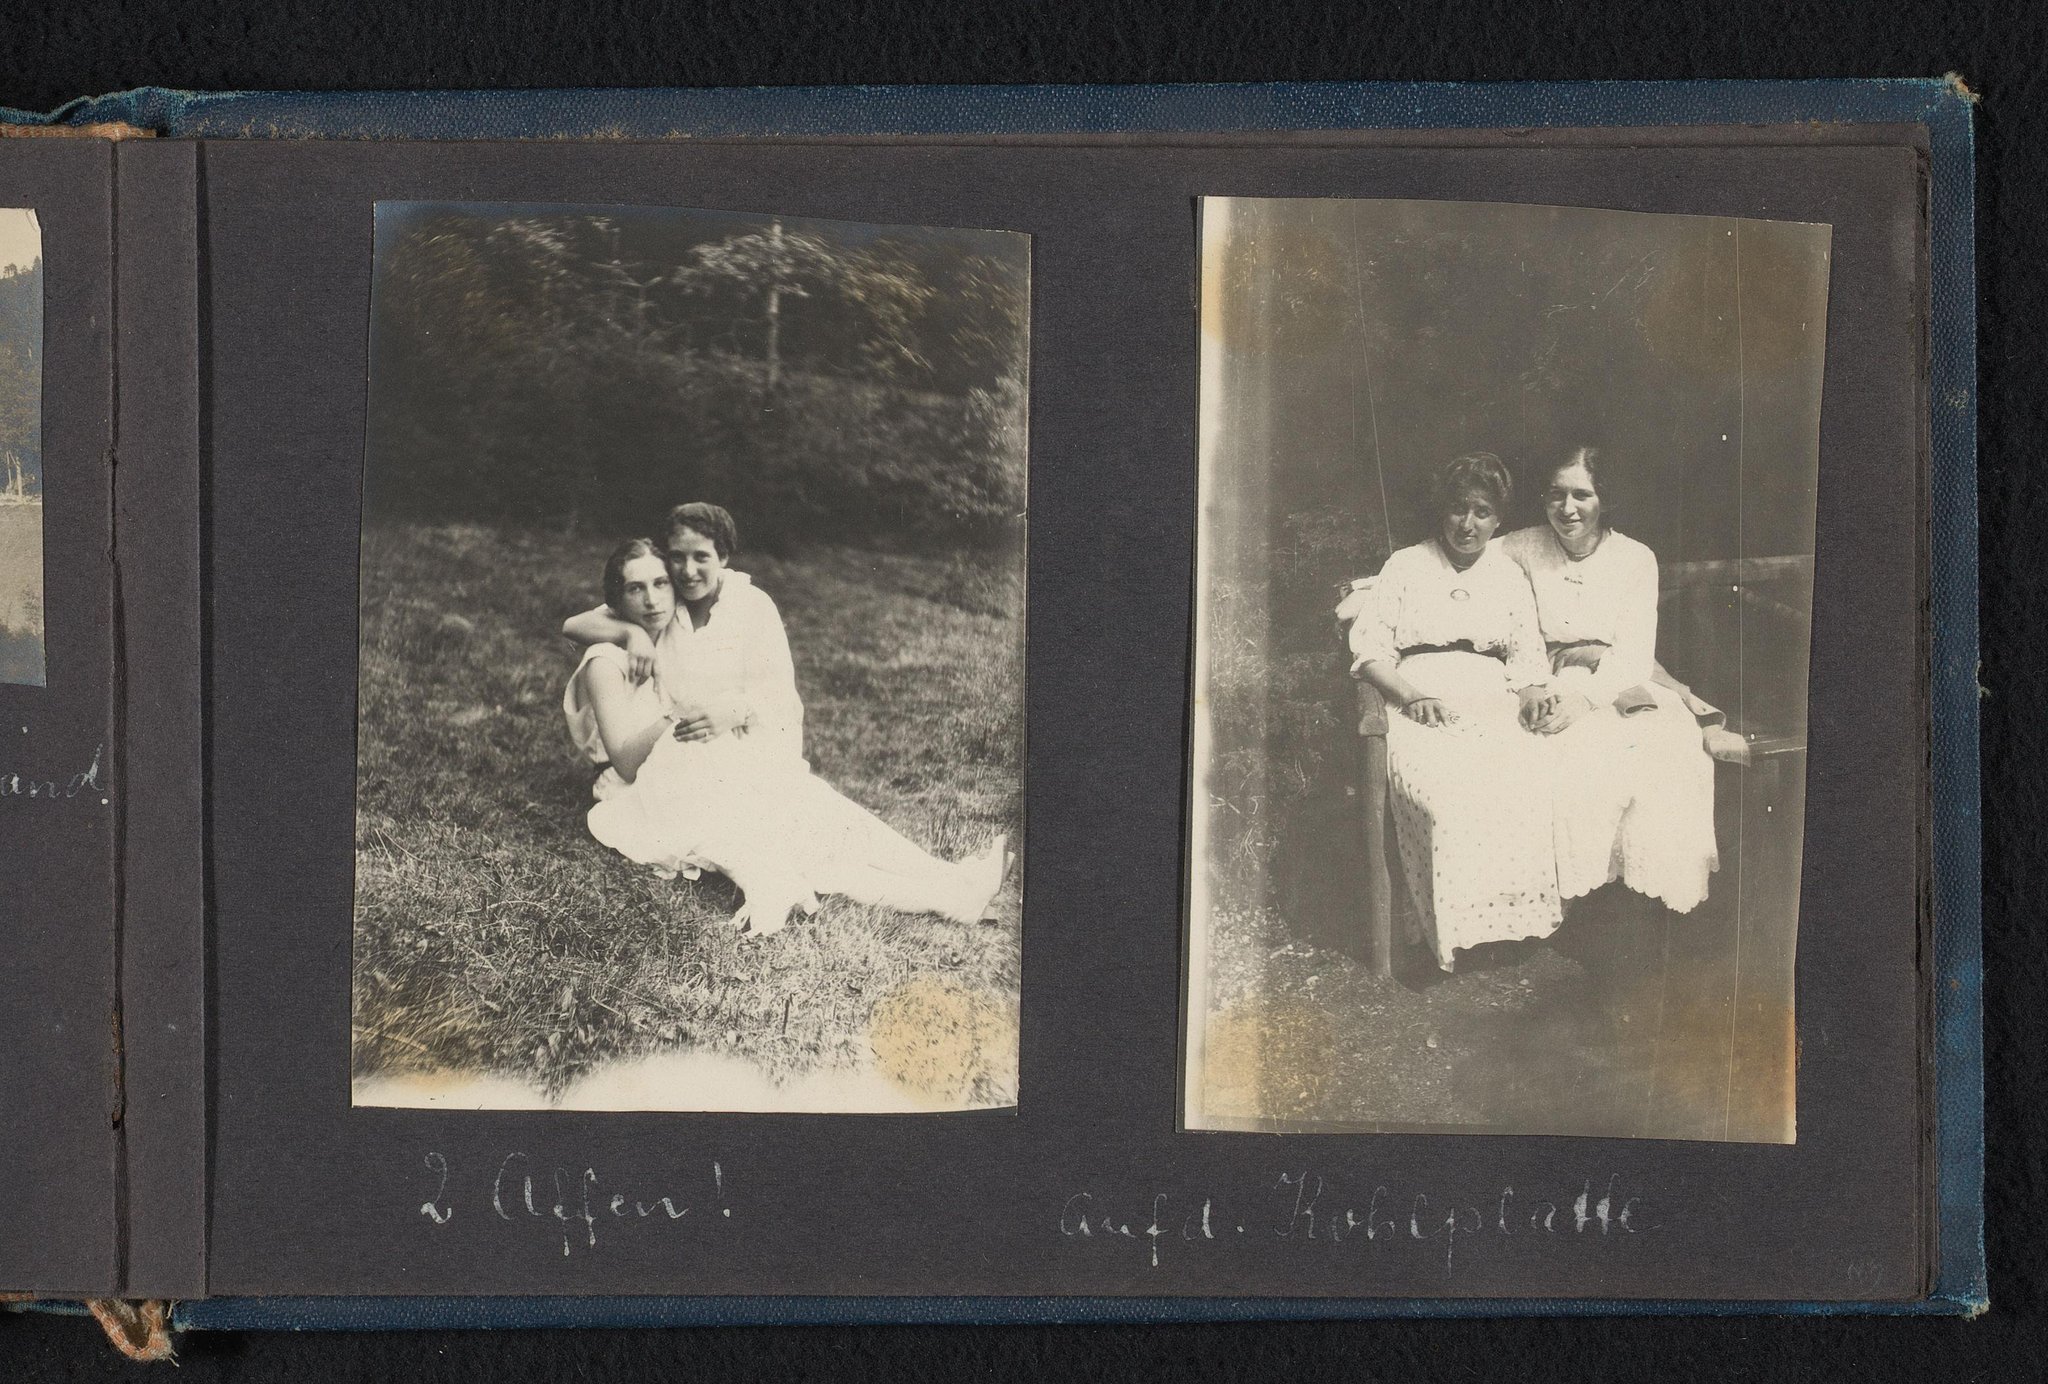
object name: photograph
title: Else met vriendin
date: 1916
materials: paper, photographic support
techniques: gelatin silver print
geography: germany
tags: else wachenheimer-moos, historical persons - bb - woman, germany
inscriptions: inscription: ‘2 Affen! / Auf d. Kohlplatte’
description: Albumblad met twee foto's van Else en een vriendin. Onderdeel van het fotoalbum van Else Wachenheimer-Moos en haar broers Arthur en Willy Moos en anderen in de periode 1913-1918.